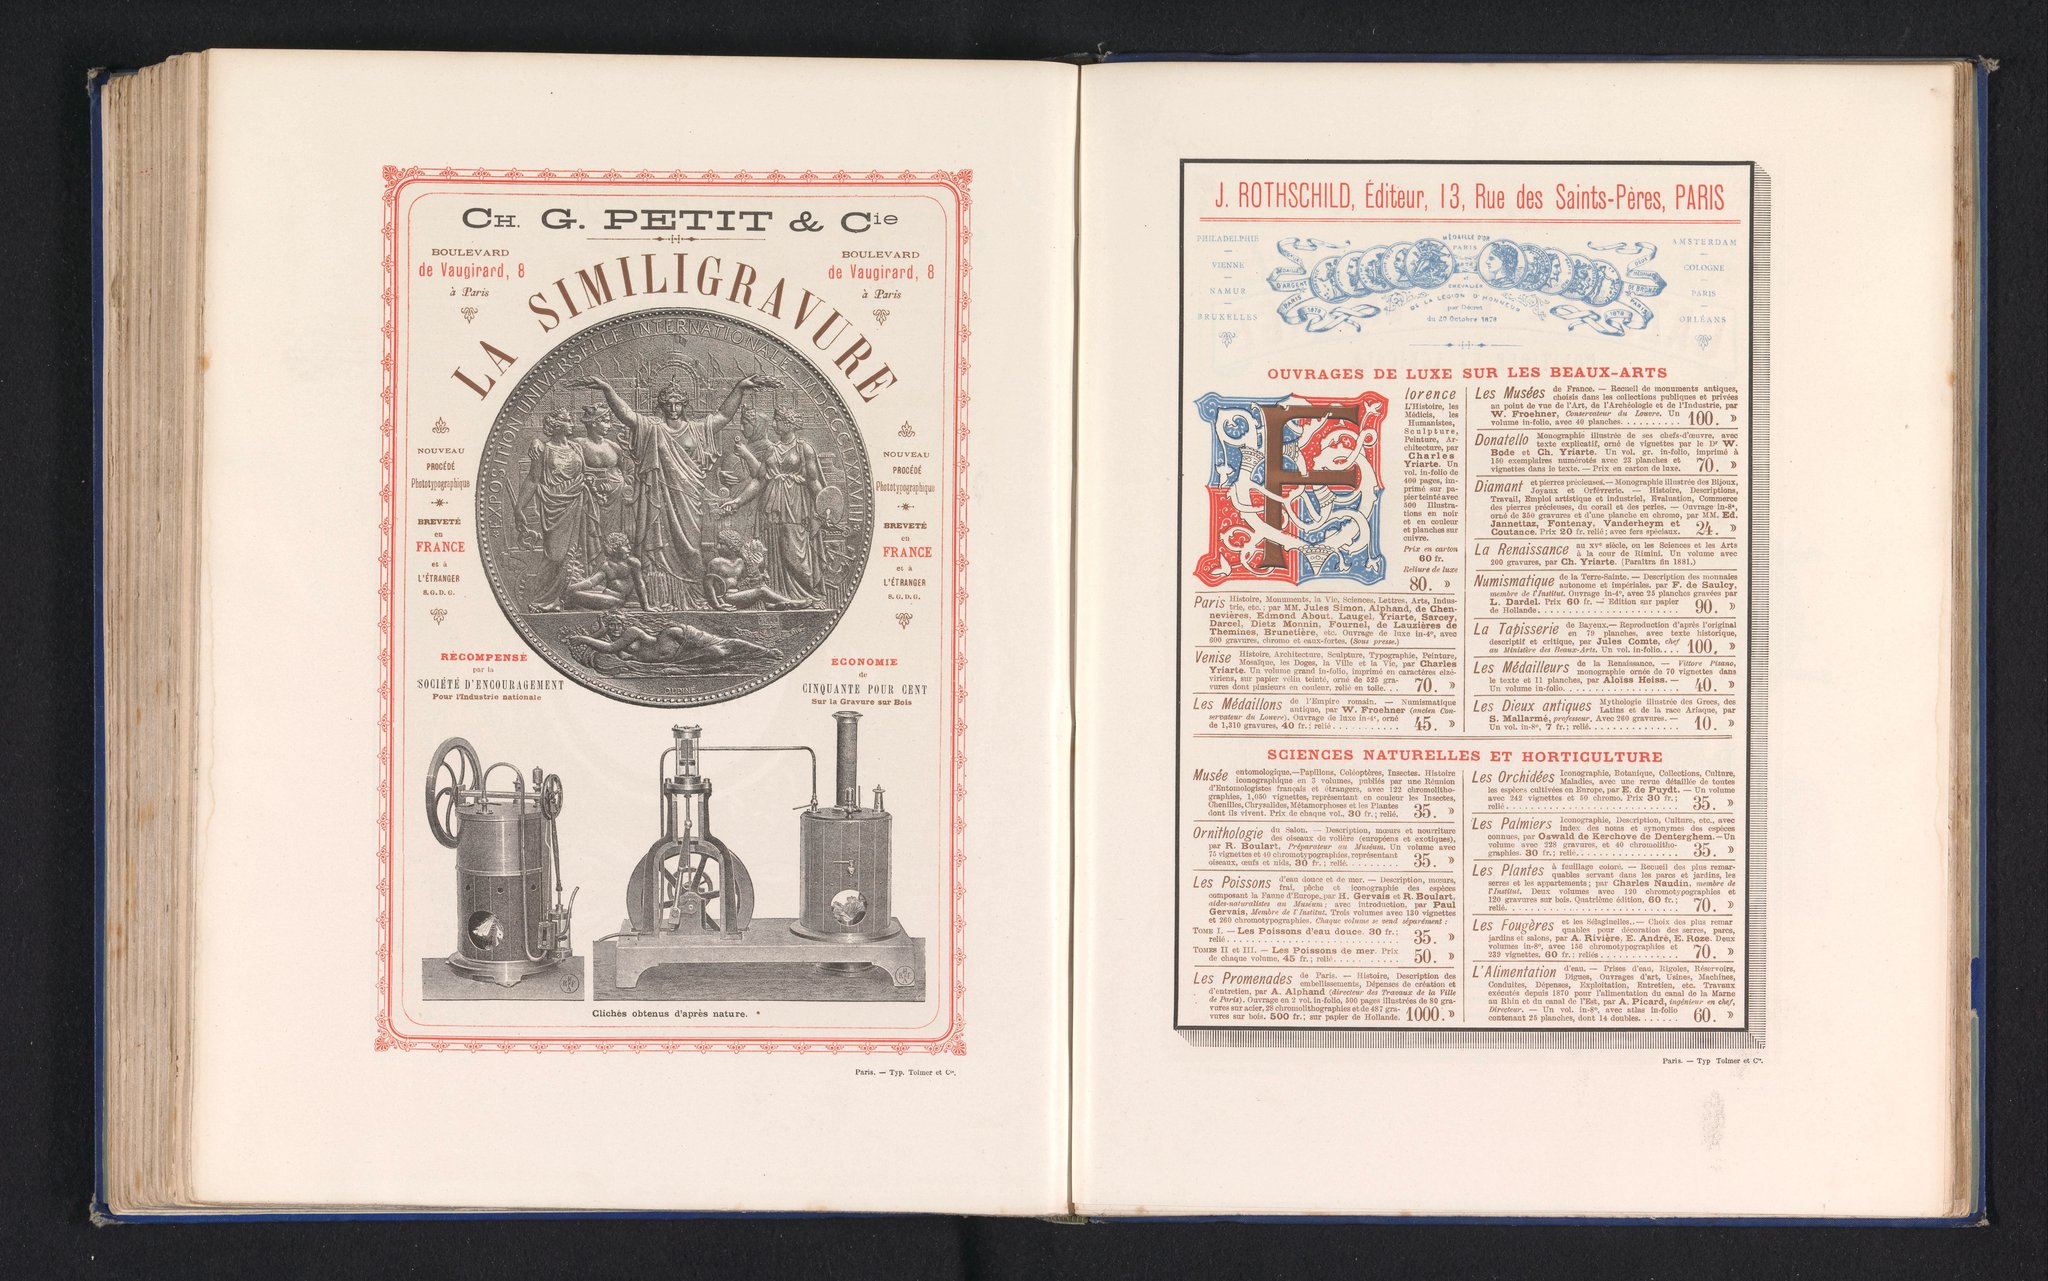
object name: photomechanical print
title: Advertentie met een herdenkingsmedaille en stoommachines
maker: Anonymous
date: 1871-1881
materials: paper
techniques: autotype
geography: france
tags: machine driven by steam, memorial medal, advertisement, notice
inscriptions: inscription: ‘Nouveau procédé Phototypographique Breveté en France et à l'étranger S.G.D.G.’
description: Boven een prent van een herdenkingsmedaille, onder twee prenten van stoommachines.